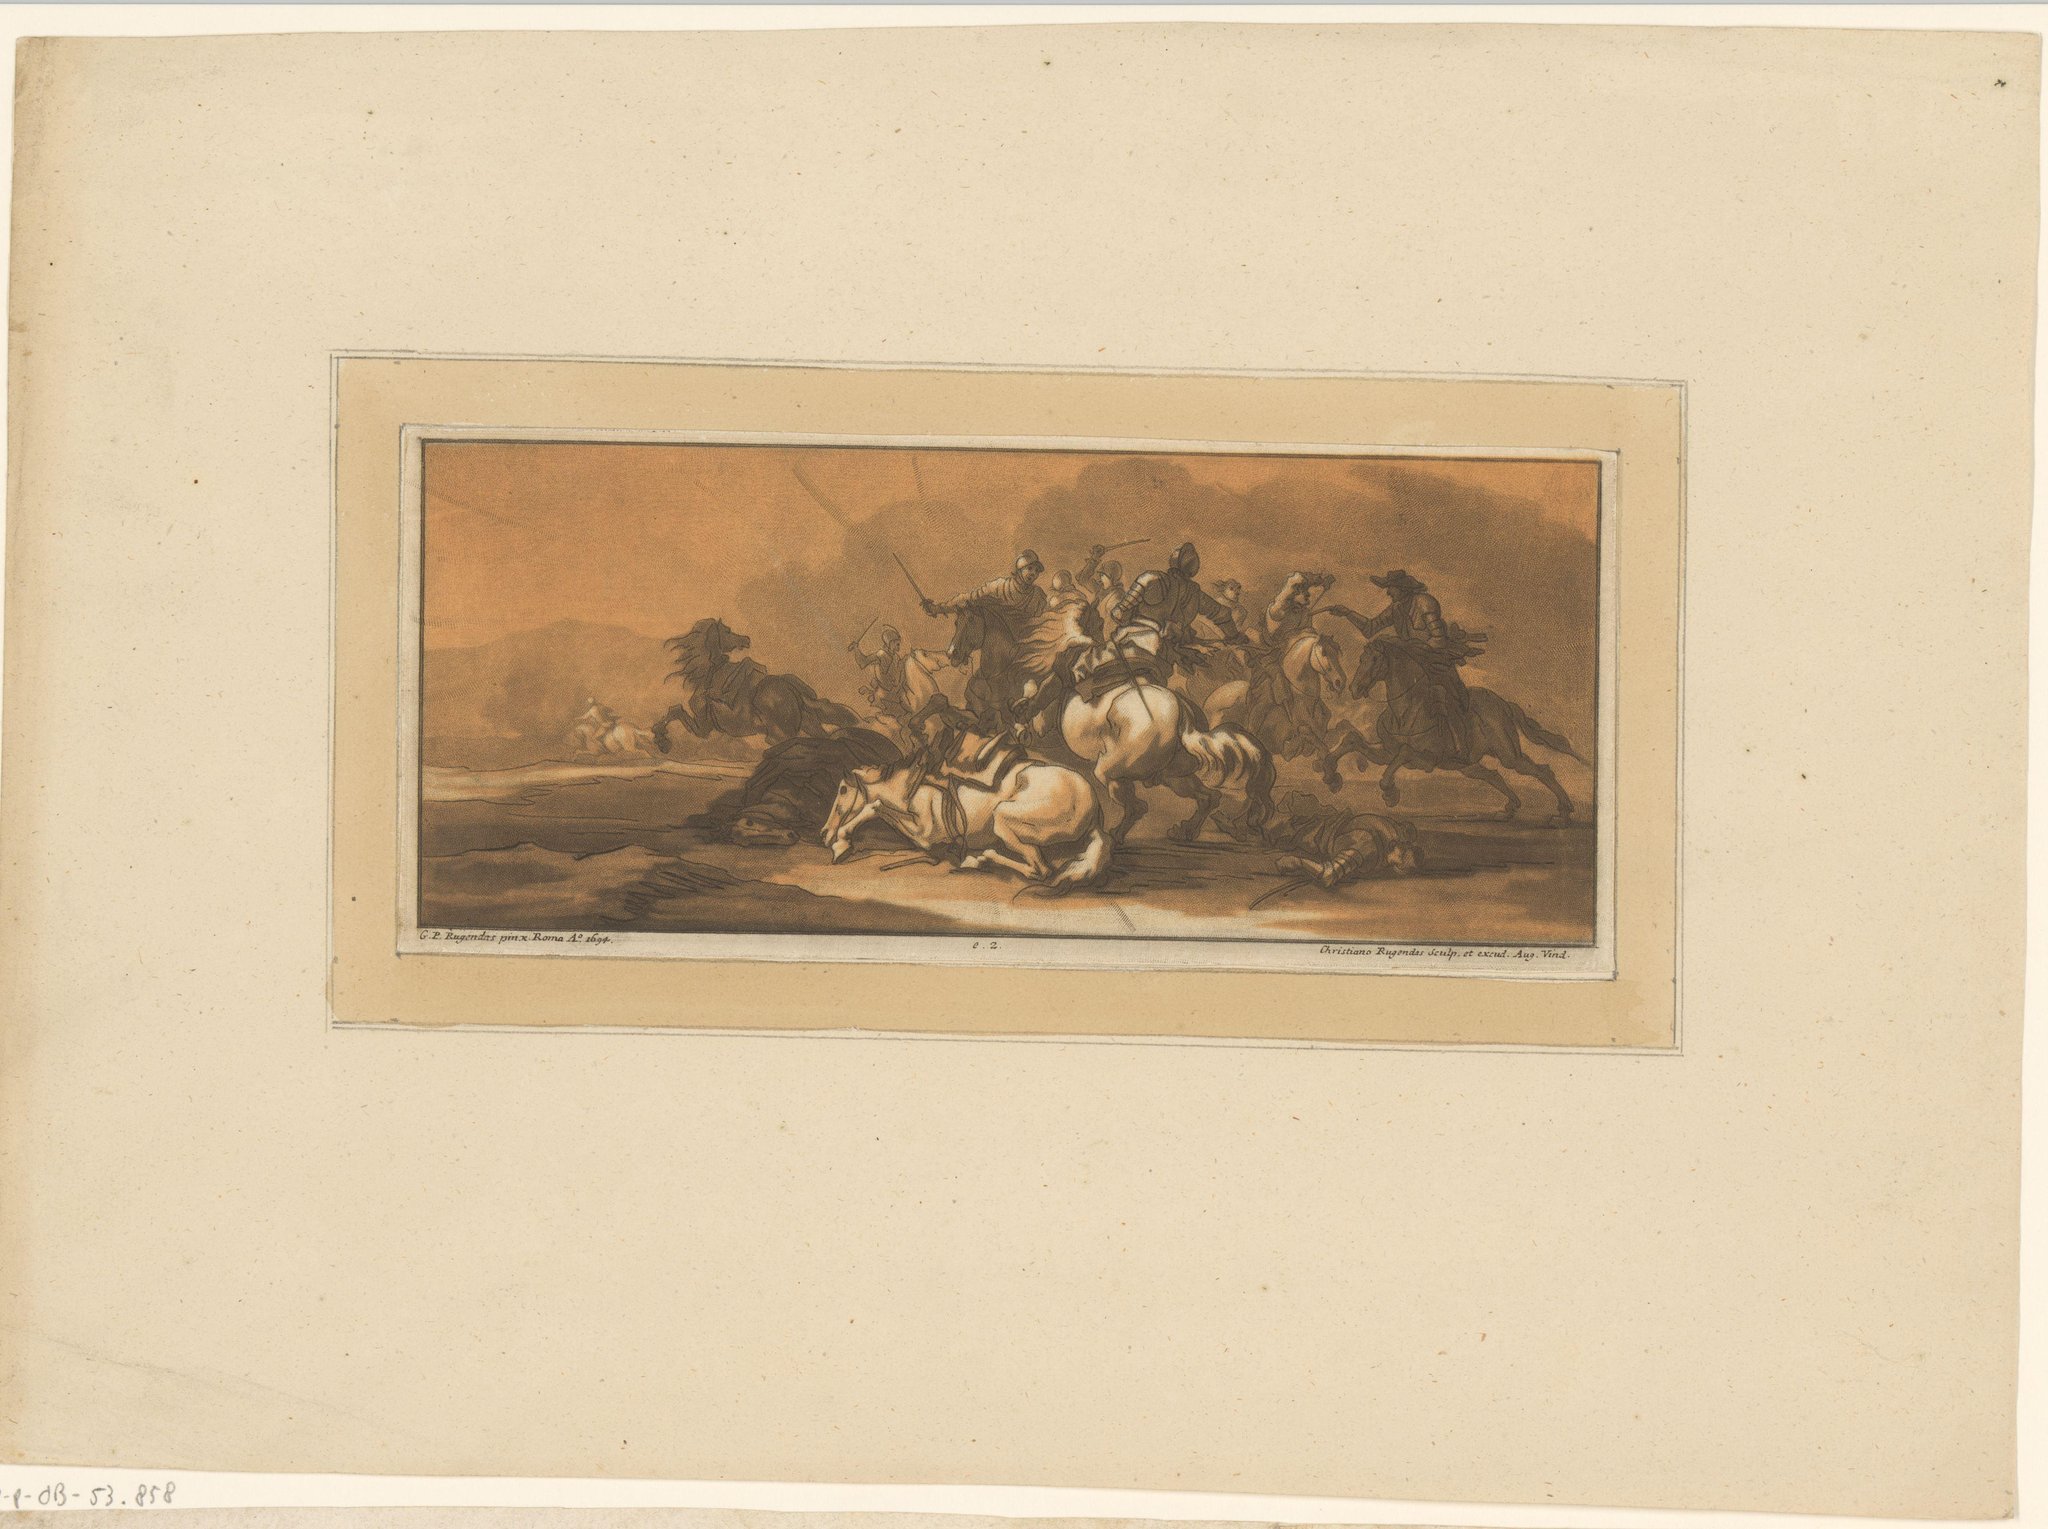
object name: print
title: Ruiters, paarden en veldslagen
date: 1718-1781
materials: paper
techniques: etching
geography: augsburg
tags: riding a horse, ass, or mule; rider, horseman, battle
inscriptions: collector's mark: Lugt 2228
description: Onderdeel van een serie van 64 prenten door Christian Rugendas naar Georg Philipp Rugendas.